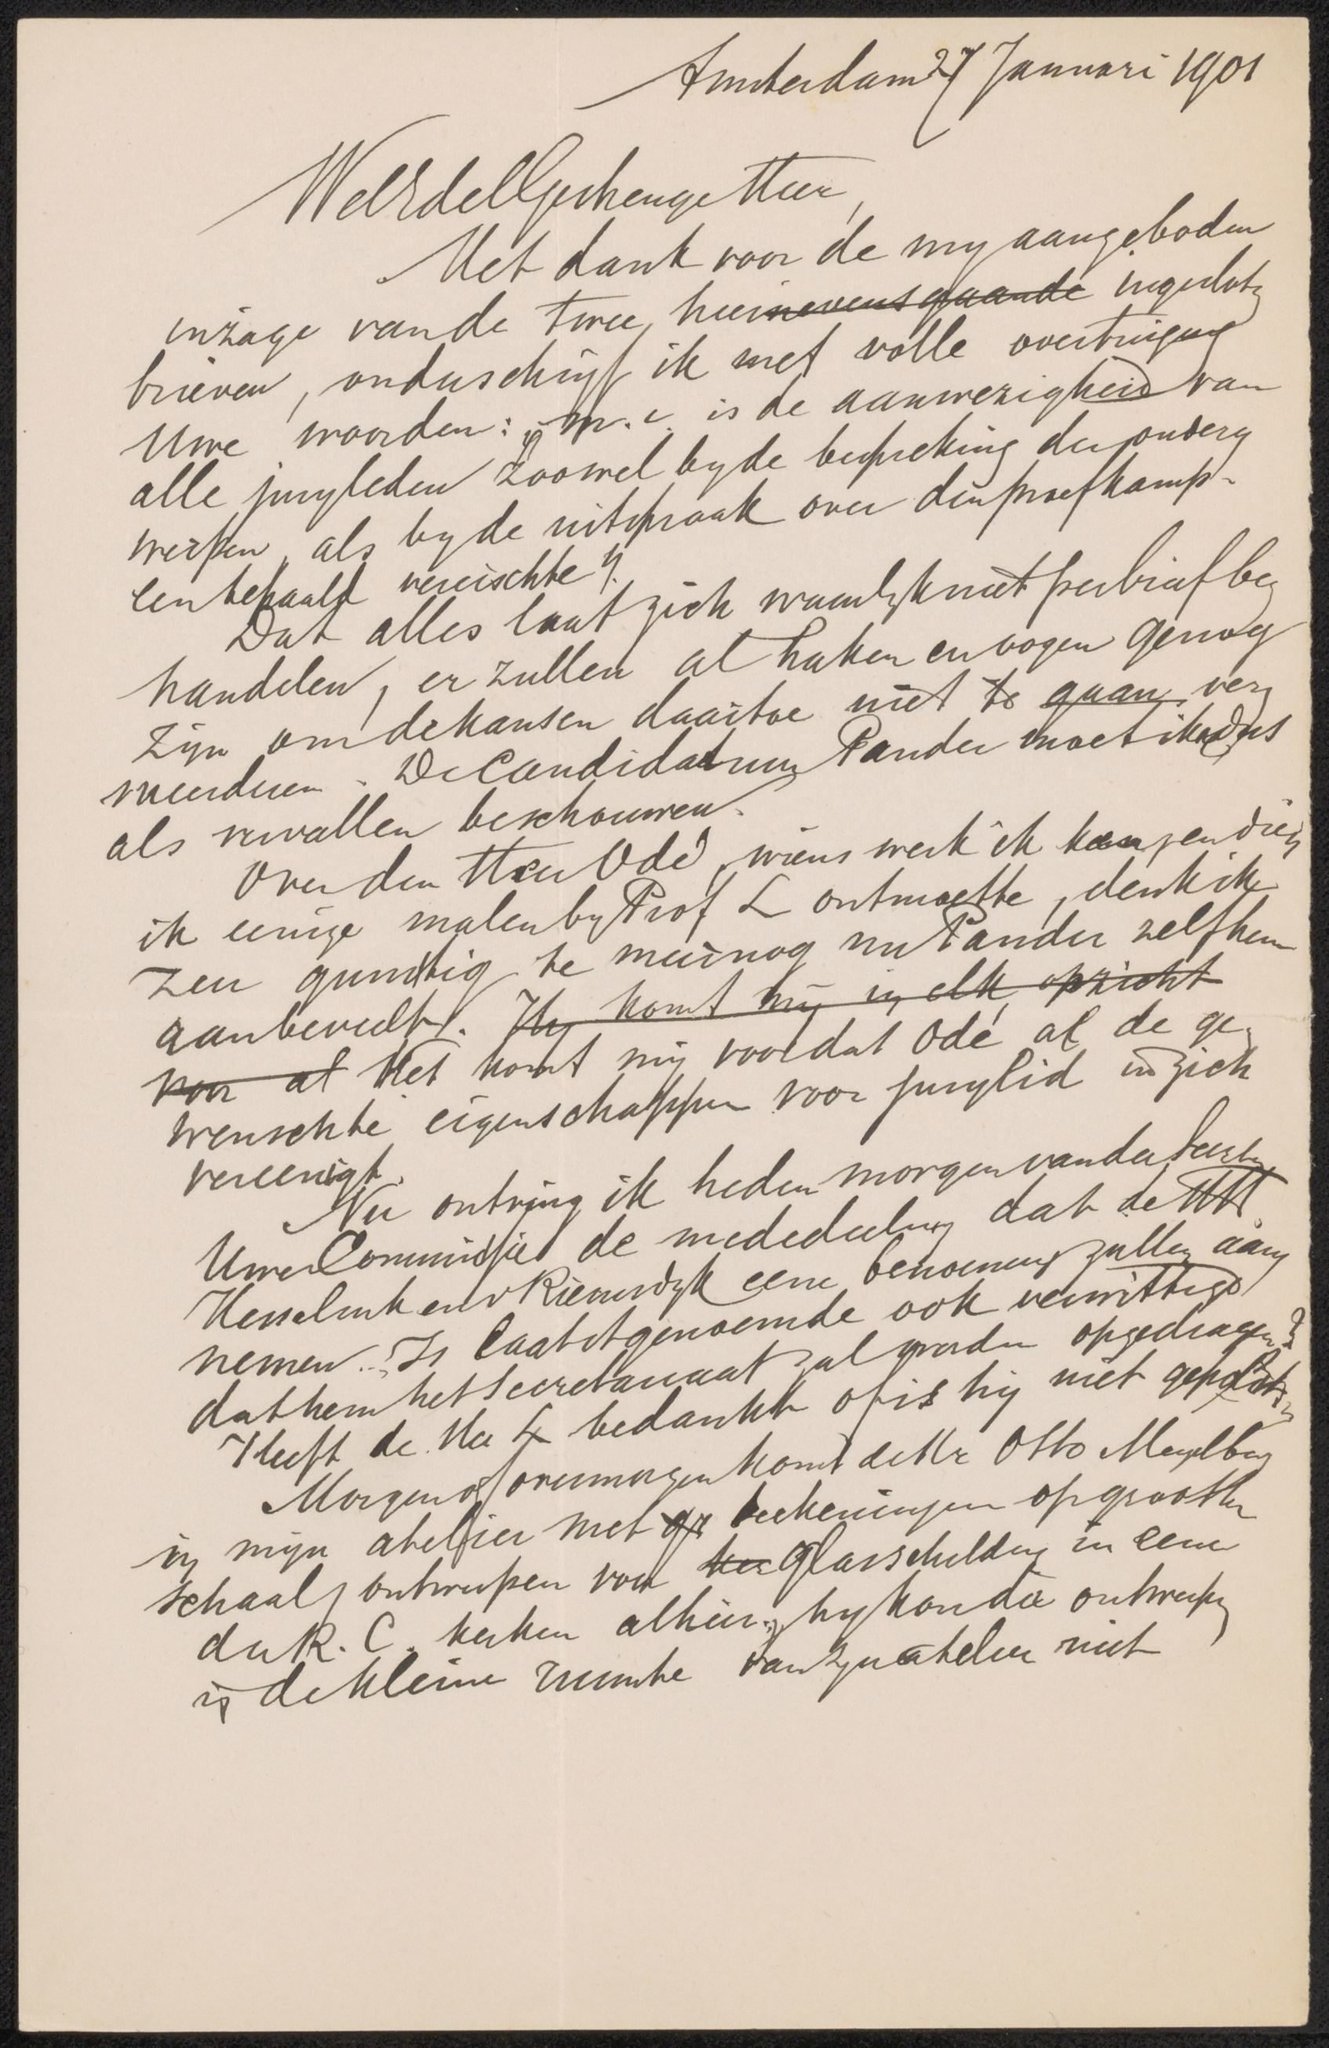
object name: letter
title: Brief aan anoniem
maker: august allebé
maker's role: draughtsman, print maker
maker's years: 1838-1927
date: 1901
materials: ink, paper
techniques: pen, writing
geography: amsterdam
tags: utrecht, otto mengelberg, arend willem maurits odé, designer, sculptor, pier pander, applied arts, arts and crafts; industrial design, distribution of awards ~ art contest